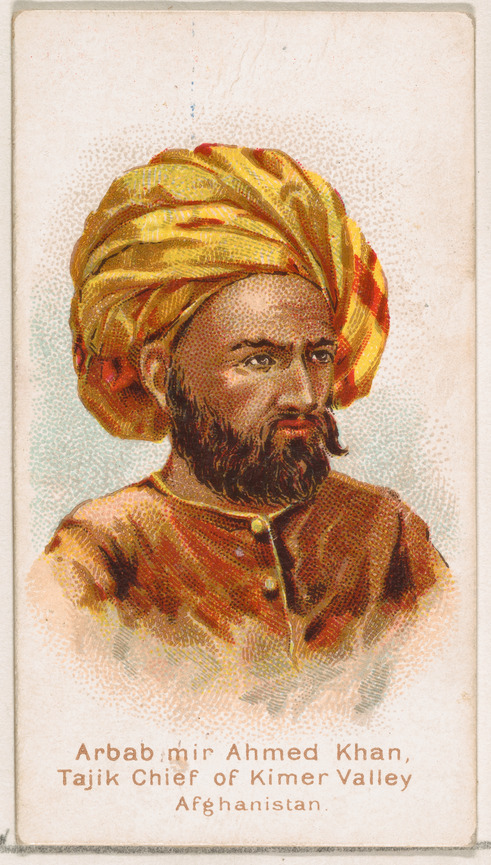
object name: print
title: Arbab mir Ahmed Khan, Tajik Chief of Kimer Valley, Afghanistan, from the Savage and Semi-Barbarous Chiefs and Rulers series (N189) issued by Wm. S. Kimball & Co.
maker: william s. kimball & company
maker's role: publisher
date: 1888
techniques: color lithograph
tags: men,portraits